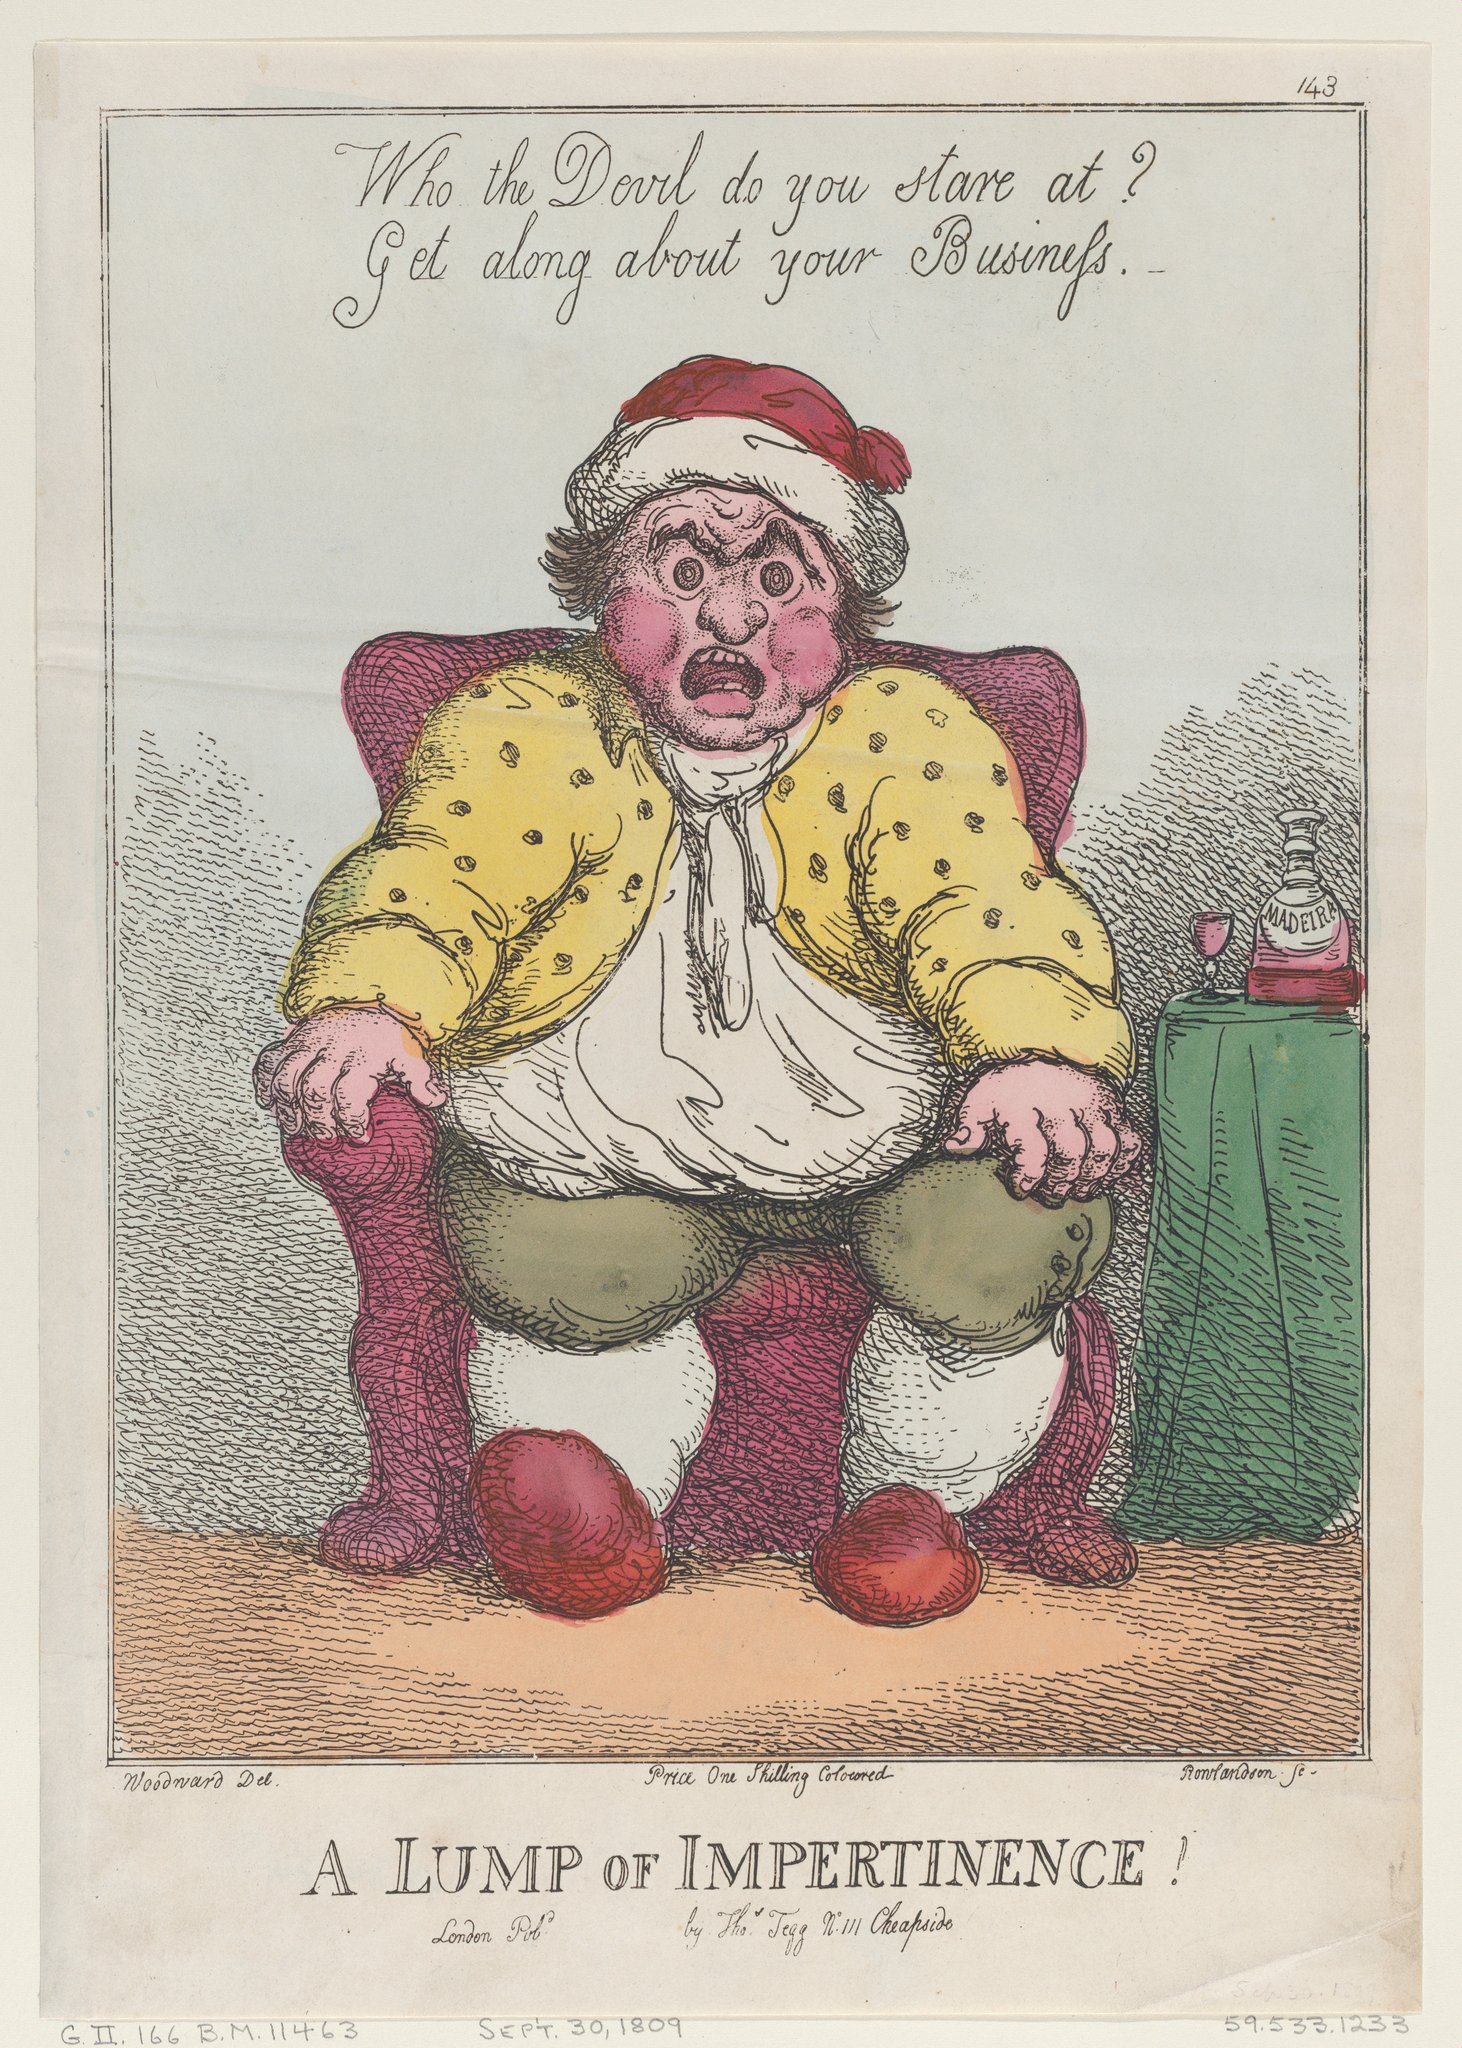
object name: print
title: A Lump of Impertinence!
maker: thomas rowlandson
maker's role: artist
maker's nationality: british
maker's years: 1757-1827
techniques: etching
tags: satire,men